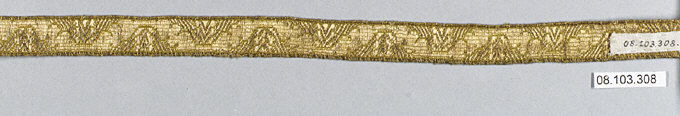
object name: galloon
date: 1601-1800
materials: metal thread